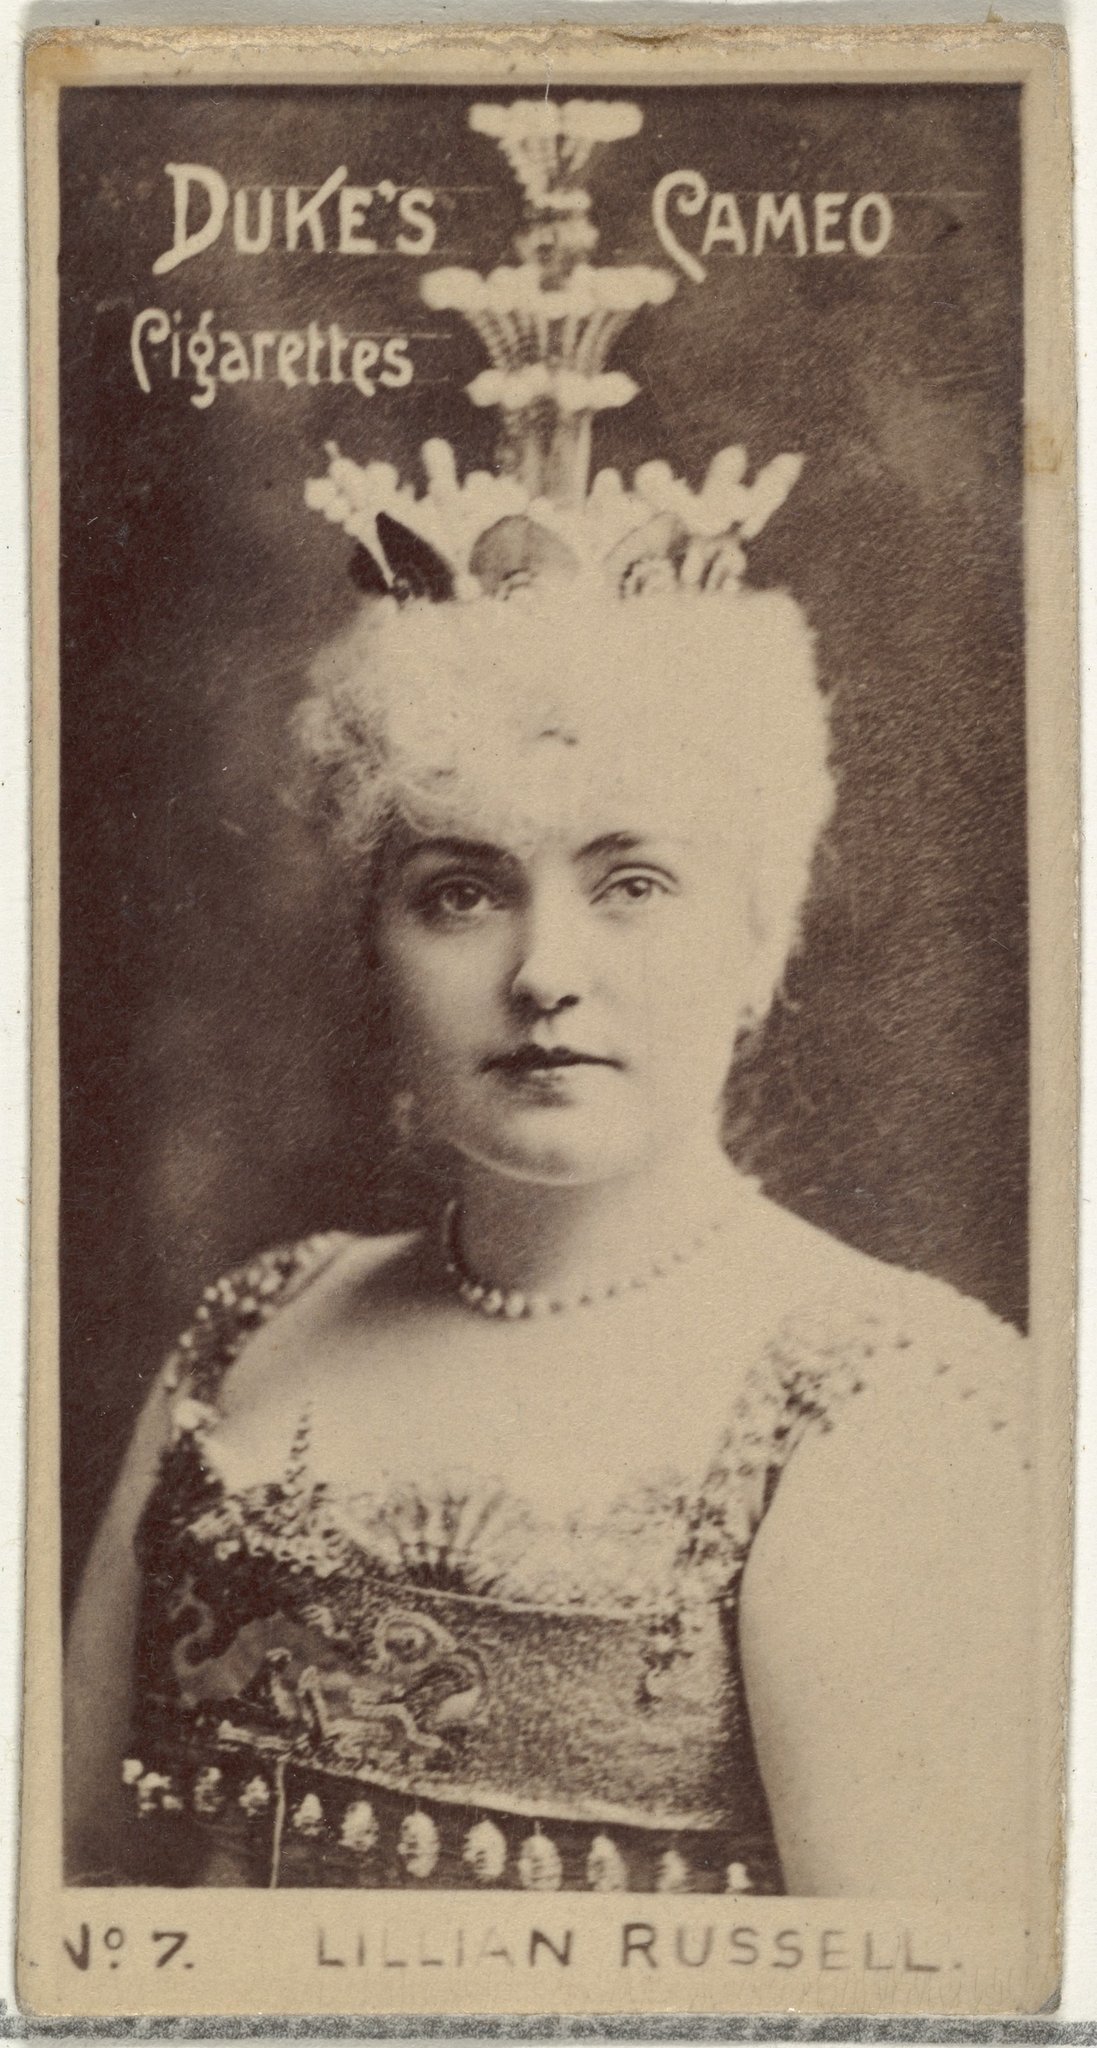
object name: photograph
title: Card Number 7, Lillian Russell, from the Actors and Actresses series (N145-4) issued by Duke Sons & Co. to promote Cameo Cigarettes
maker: w. duke, sons & co.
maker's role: publisher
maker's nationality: american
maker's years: 1870-1920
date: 1880-1889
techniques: albumen silver print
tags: portraits,women,actresses